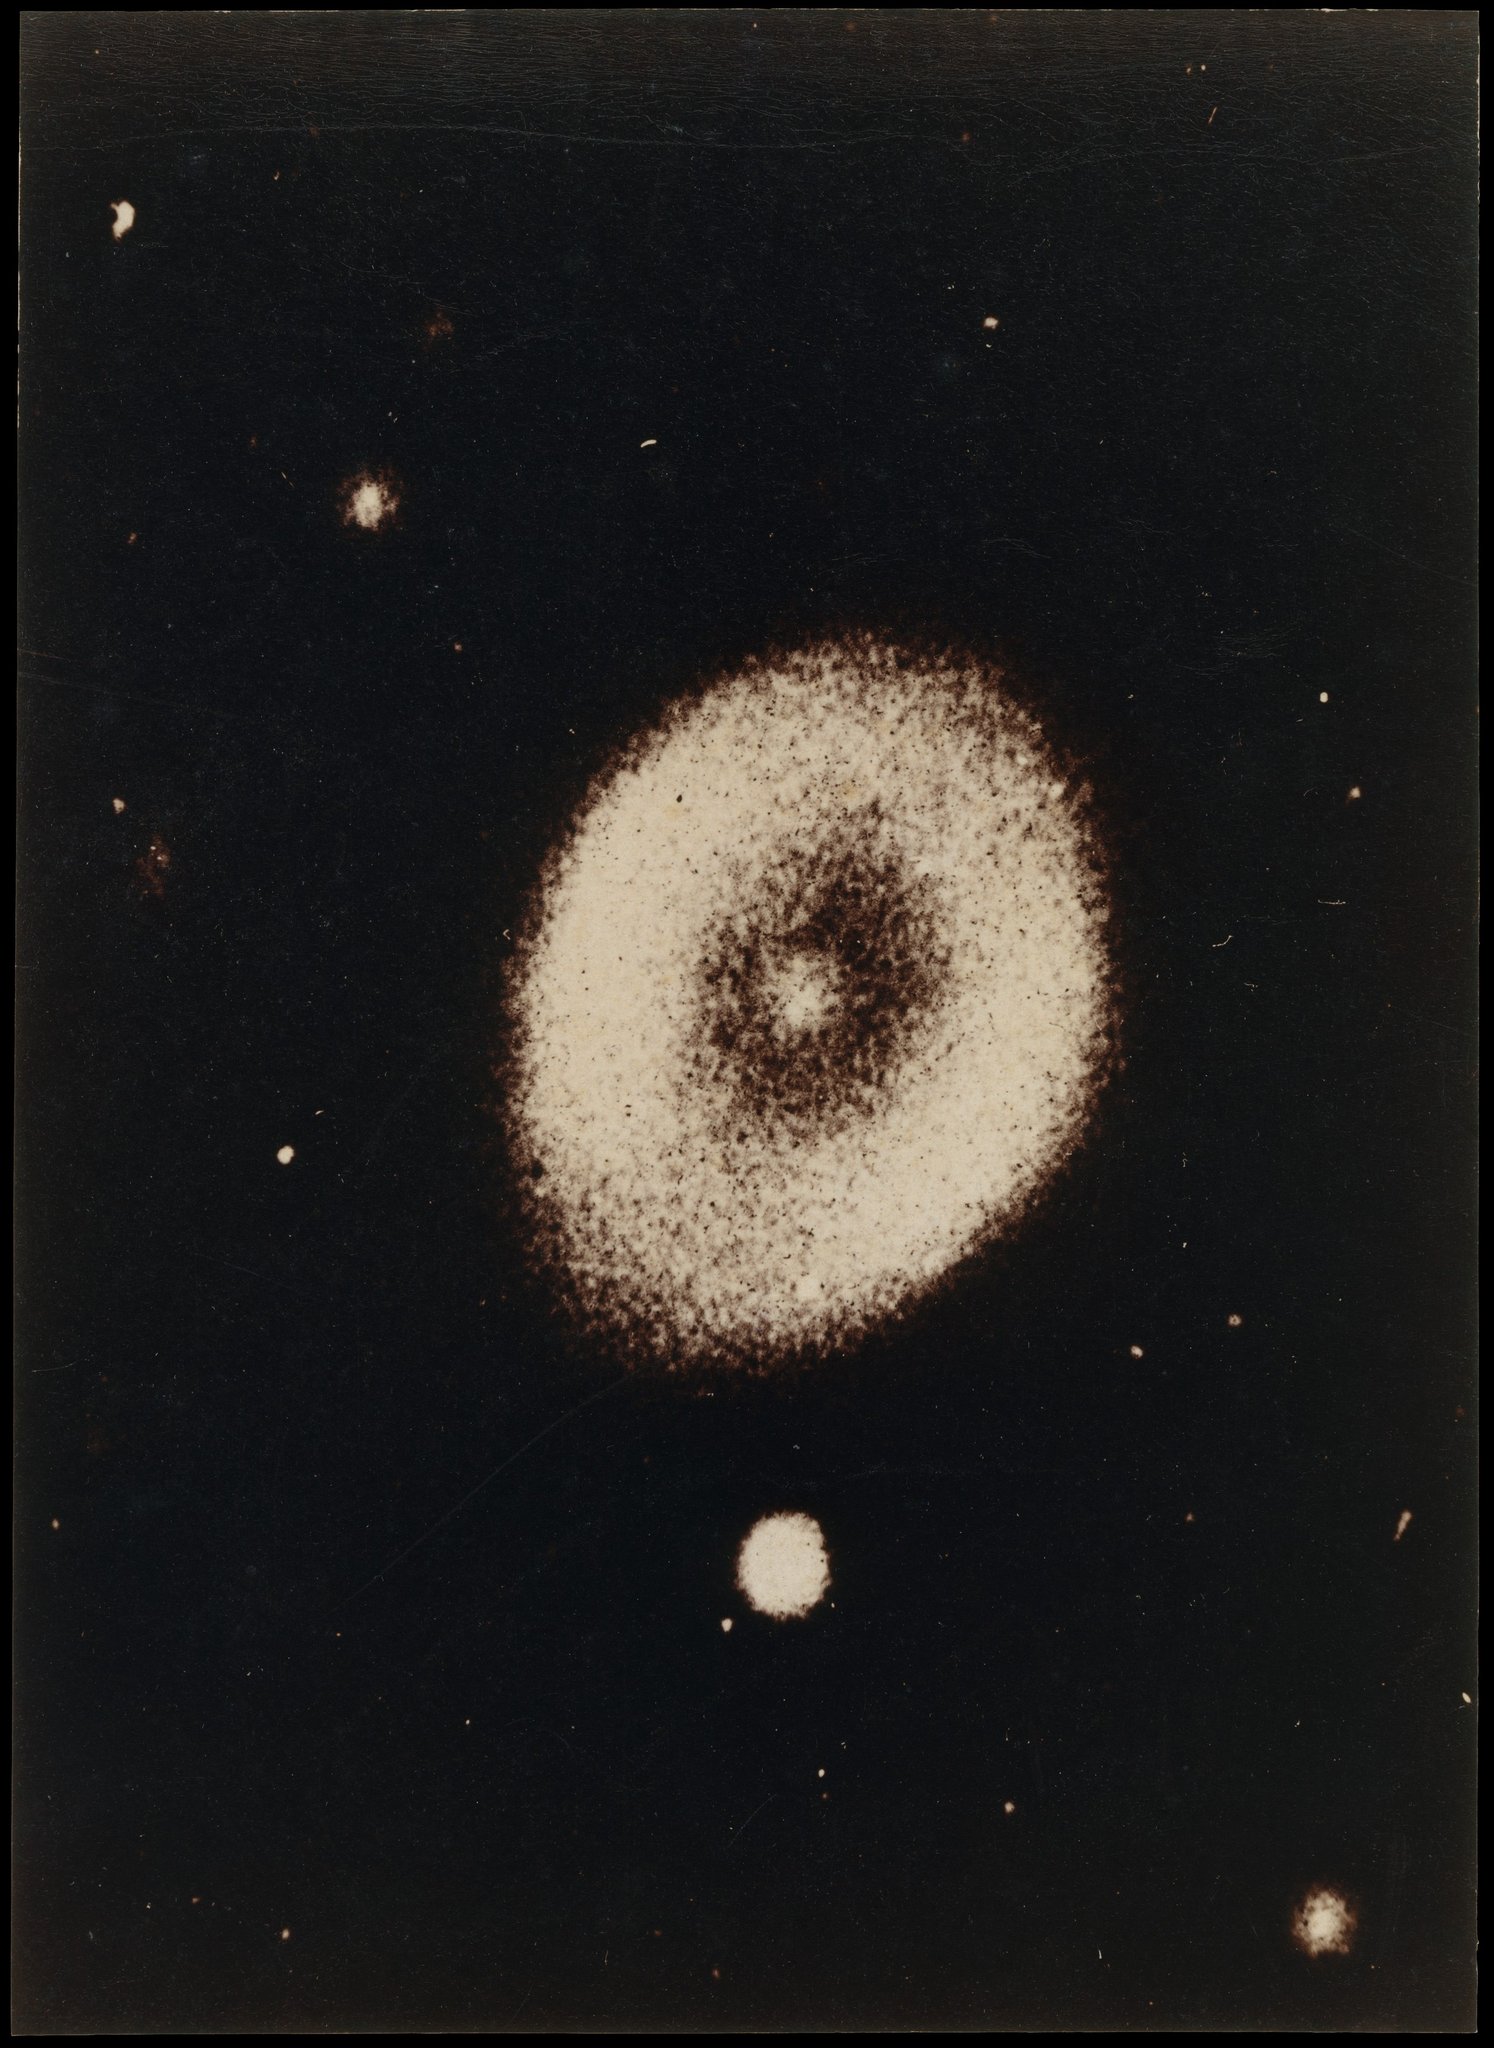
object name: photograph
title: Nebuleuse de la Lyre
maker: paul henry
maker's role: artist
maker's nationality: french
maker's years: 1848-1905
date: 1885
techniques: albumen silver print, glass negative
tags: astronomy